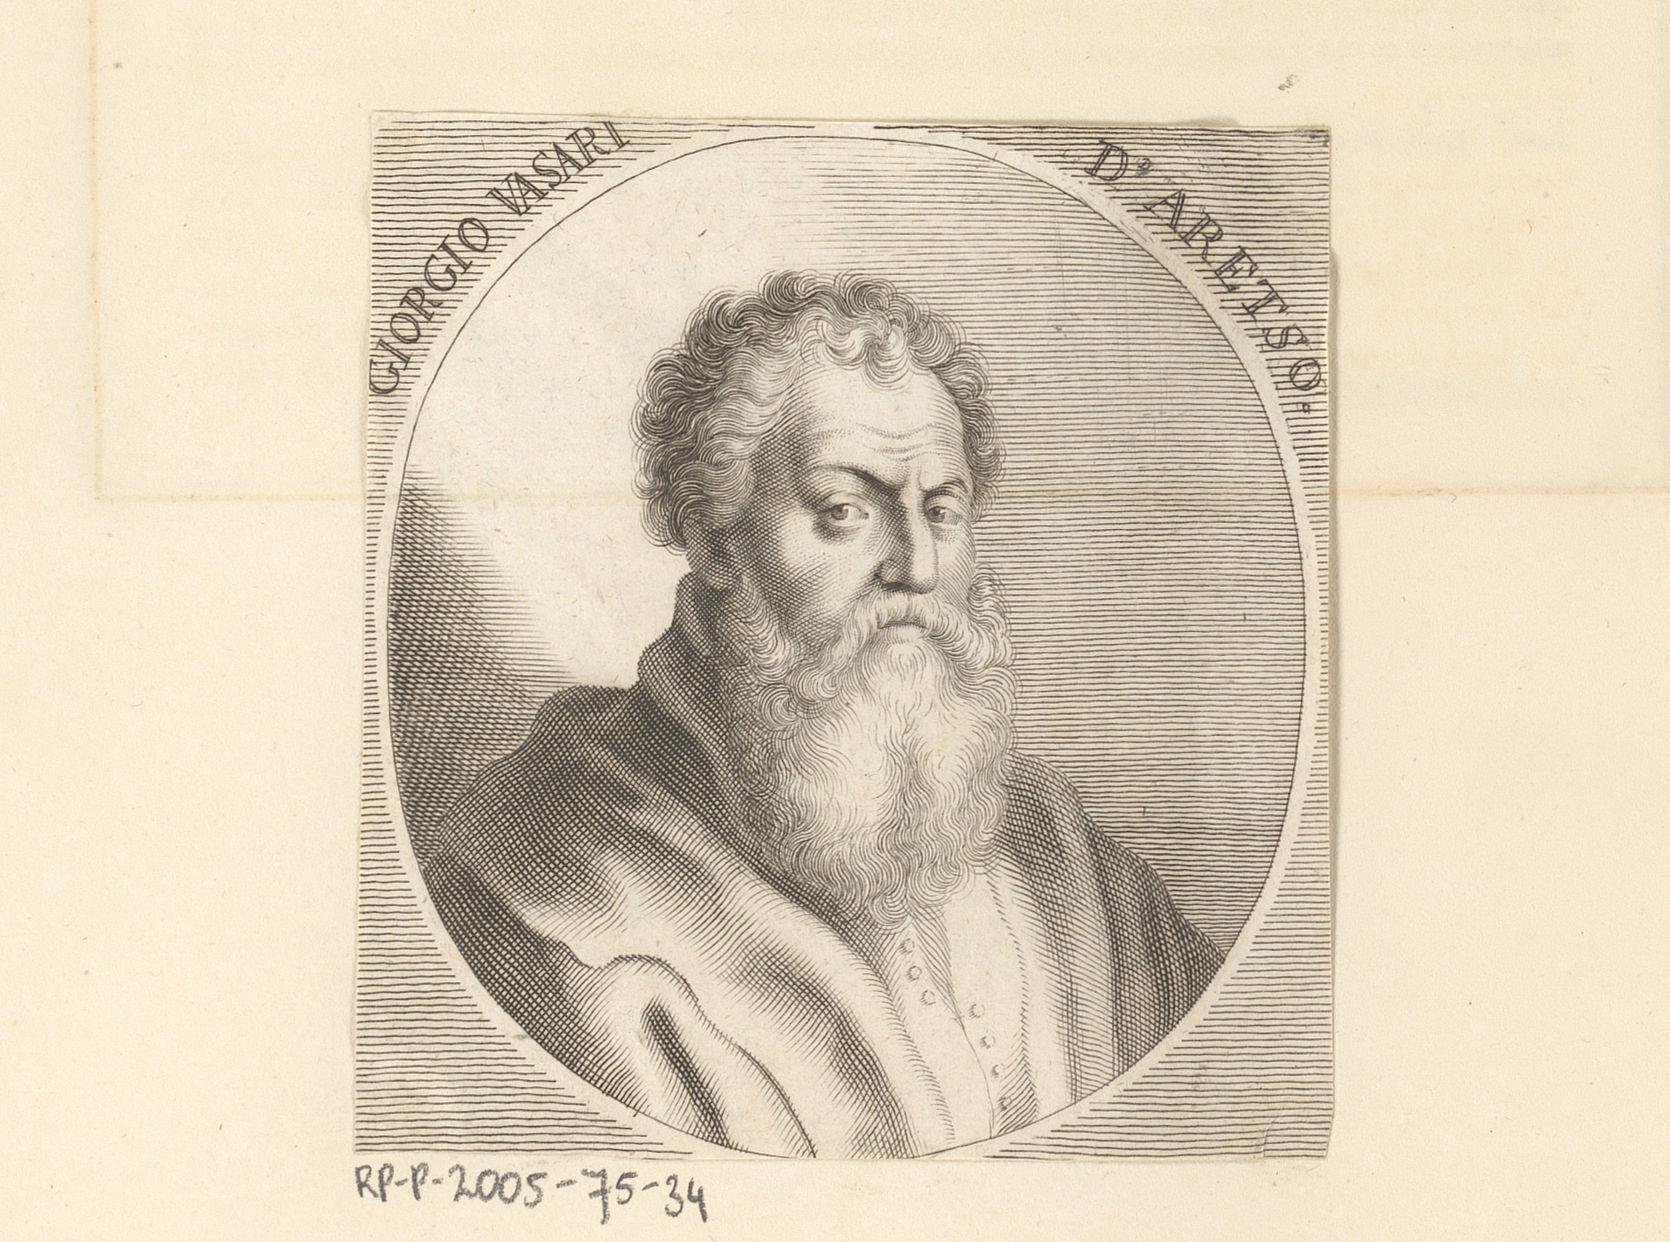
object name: print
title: Portret van Giorgio Vasari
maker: philipp kilian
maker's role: print maker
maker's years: 1628-1693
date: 1650-1776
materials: paper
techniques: engraving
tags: draughtsman, giorgio vasari, historical persons, portrait, self-portrait of painter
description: Andere staat van deze prent gebruikt in: Sandrart, Joachim von. Teutsche Academie der Bau- Bildhauer- und Maler-Kunst: worinn die Regeln und Lehrsätze dieser Künste gegeben. 14 dln. Neurenberg: erven Johann Andreas Endter, [1774], dl. 7, p. S. De samensteller heeft deze prent in het album geplakt als illustratie bij: Pilkington, Matthew en Johann Heinrich Füssli. A dictionary of painters, from the revival of the art to the present period. 4 dln. Londen: John Crowder, 1805, dl. 4, p. 595.